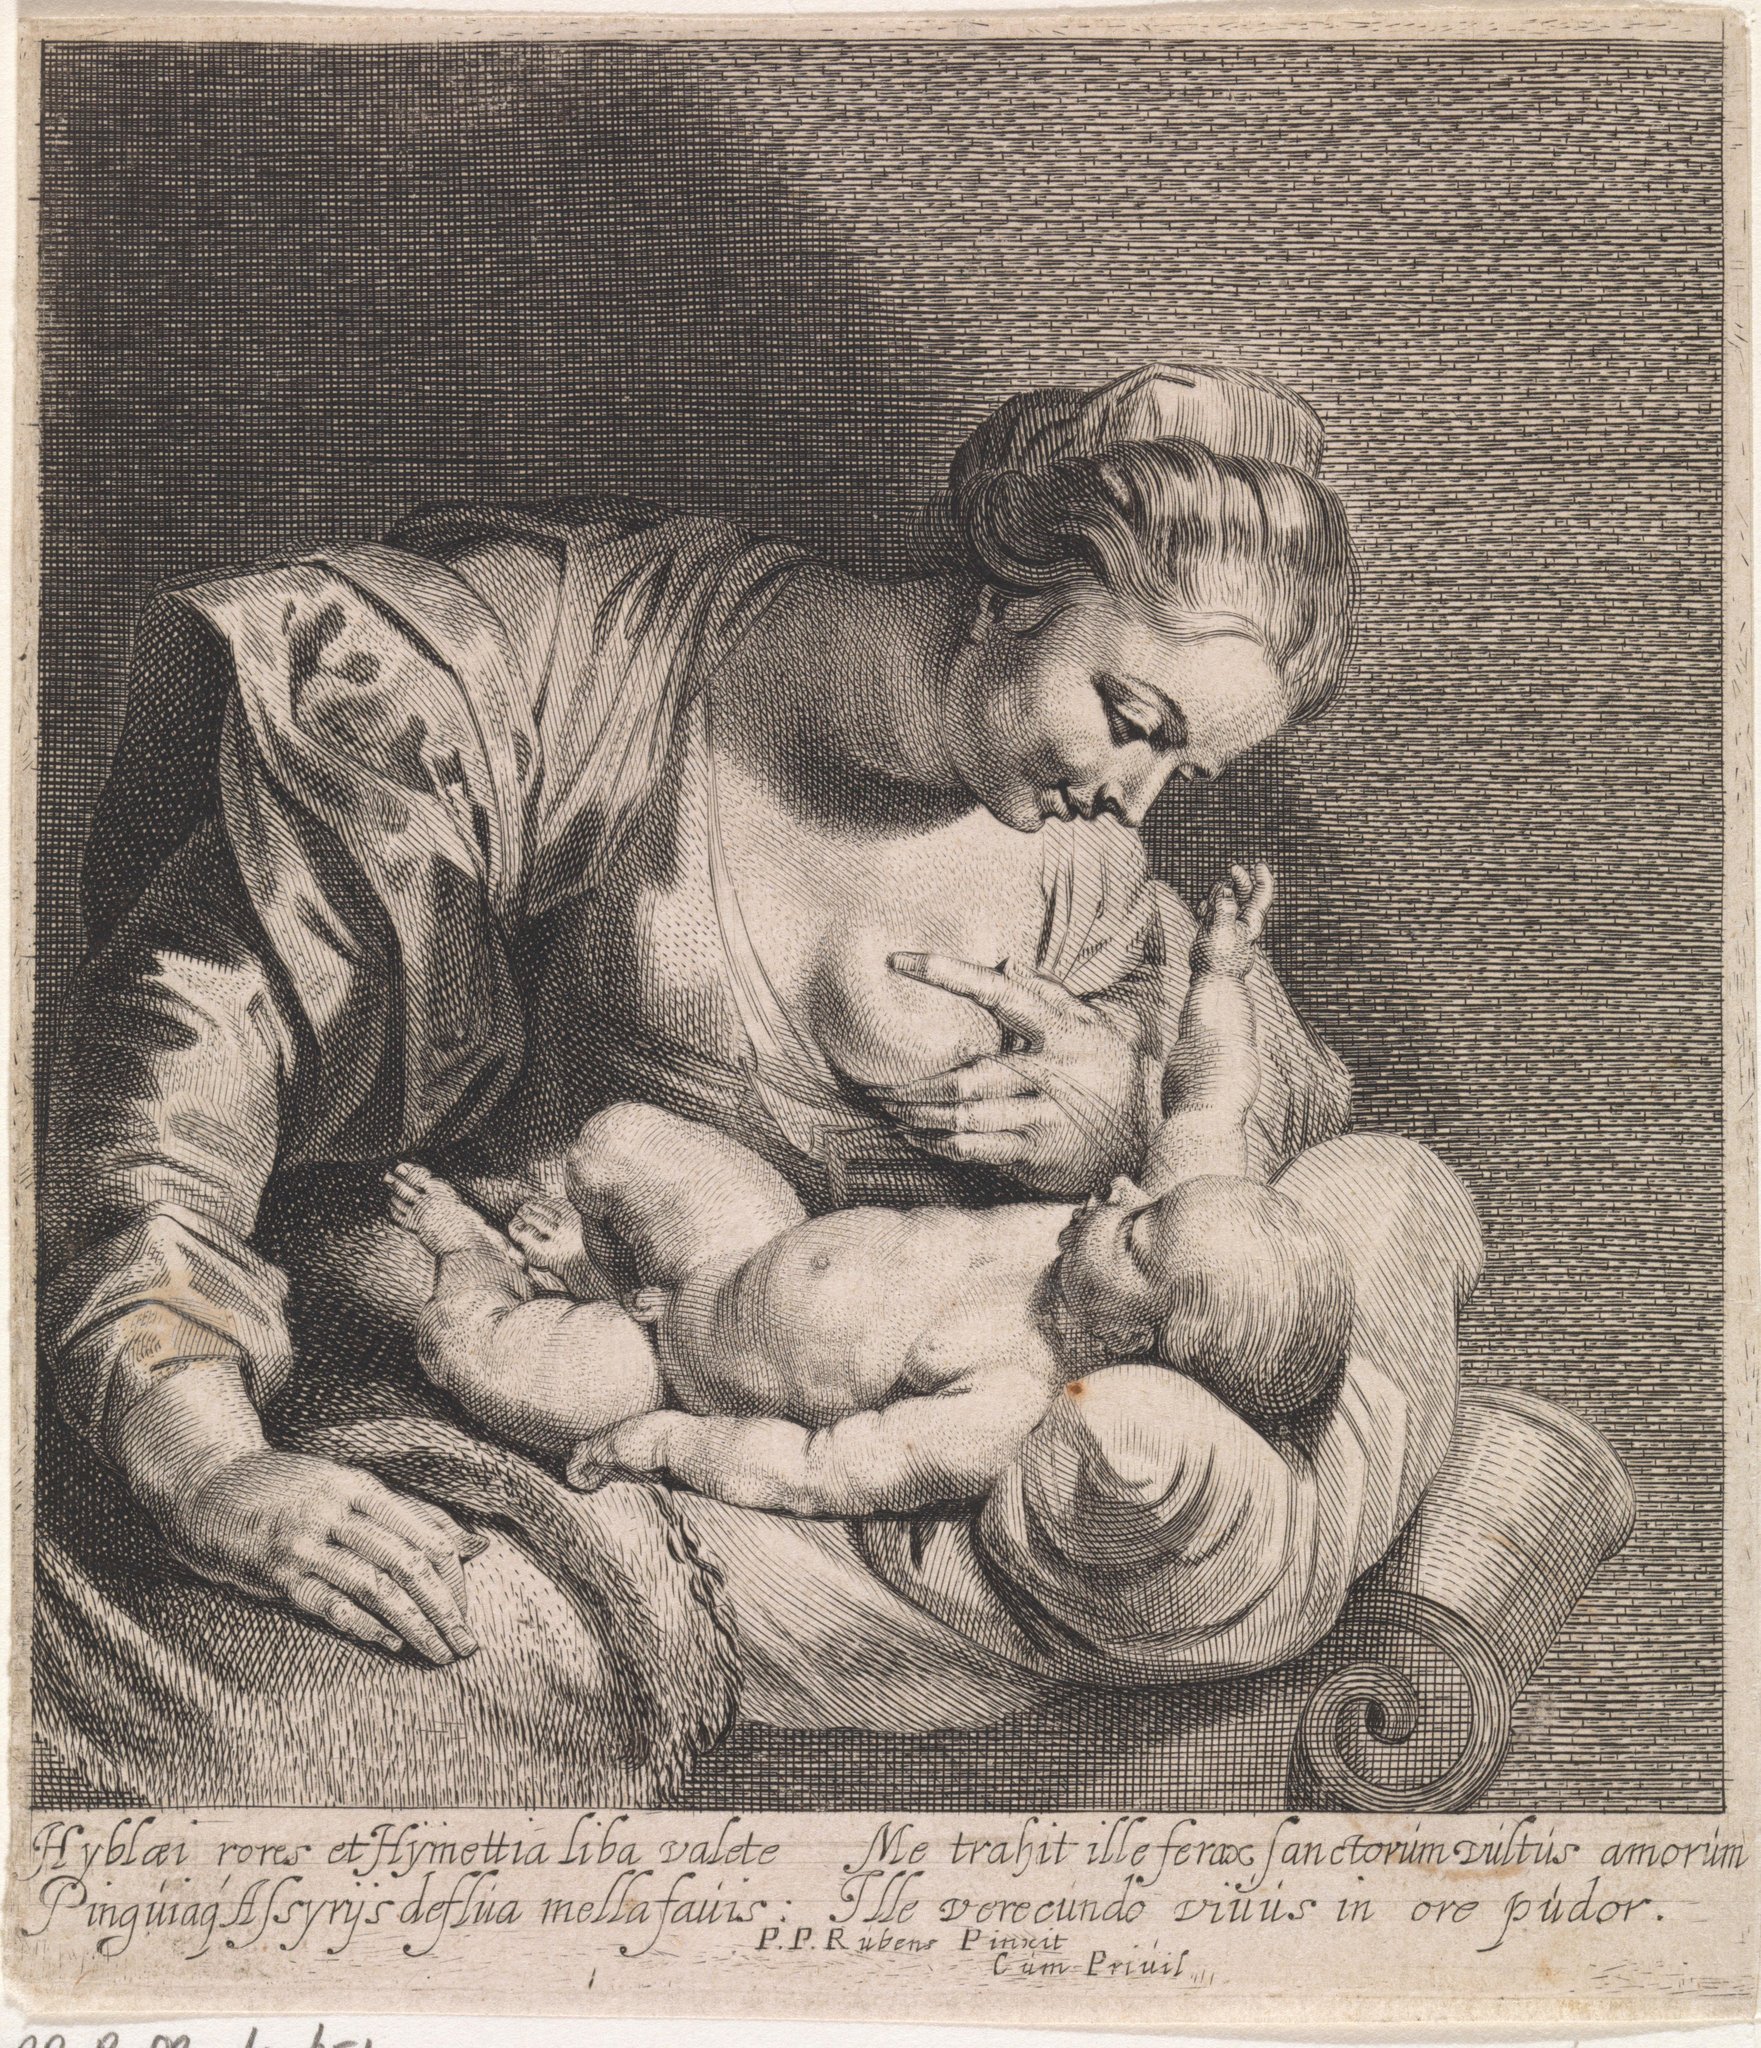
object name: print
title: Maria met het Christuskind dat op een kussen ligt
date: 1623-1686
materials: paper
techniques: engraving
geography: haarlem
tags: mary giving milk from her breasts, 'lactatio', 'ablactatio'; christ not drinking, mary's breast bare ~ madonna-representations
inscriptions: collector's mark: Lugt 240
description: Maria staat voorover gebogen over het Christuskind dat op een kussen ligt. Zij geeft hem de borst.